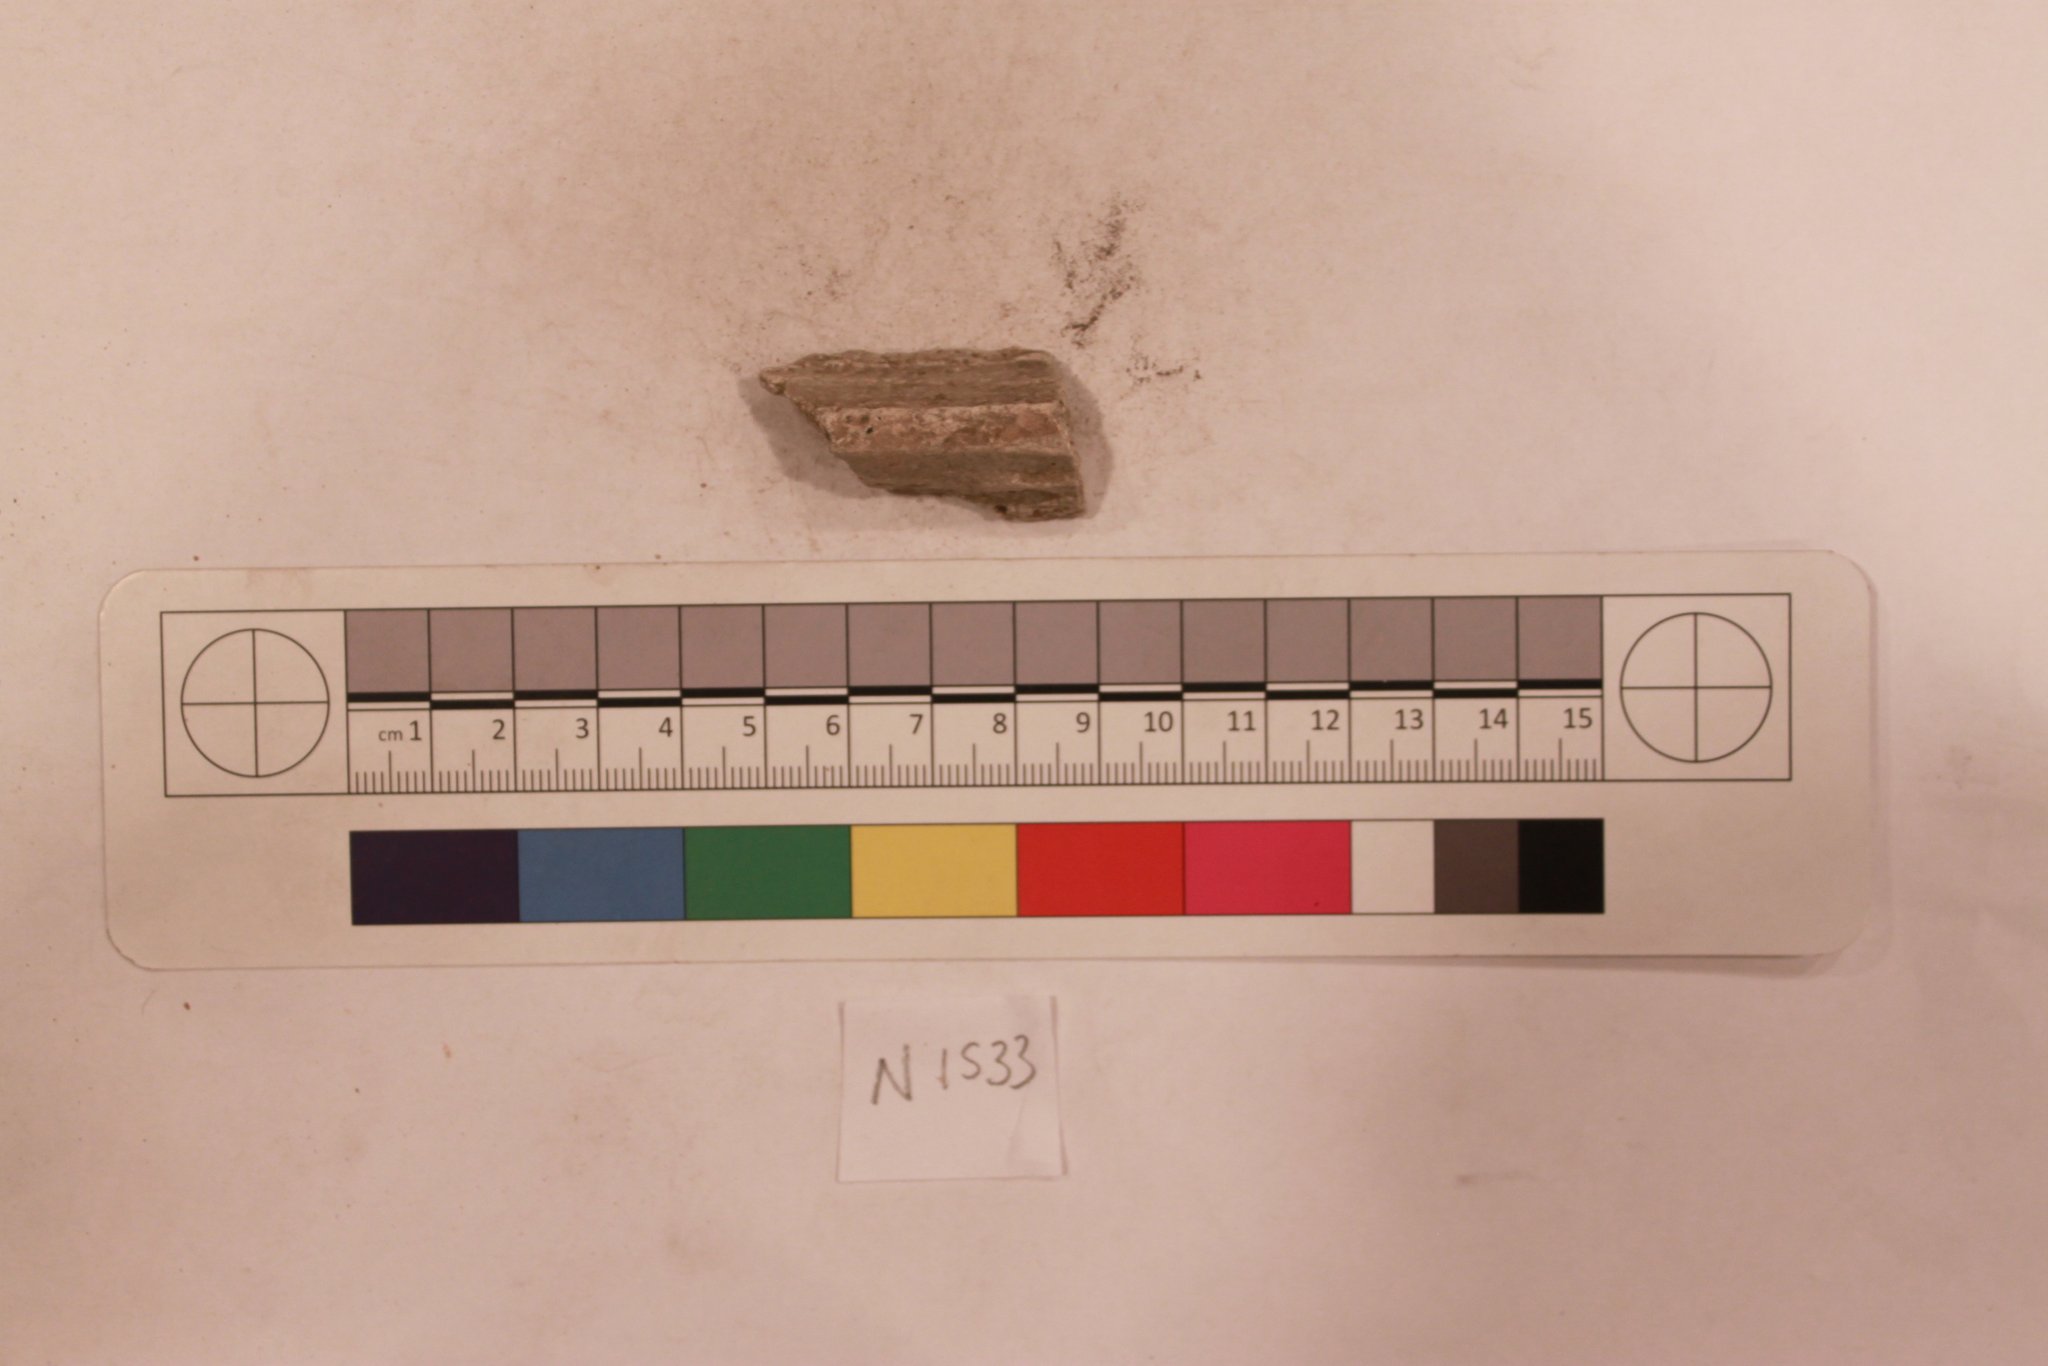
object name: fragment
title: Stucco Fragment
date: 701-1200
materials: plaster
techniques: carving, painting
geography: iran